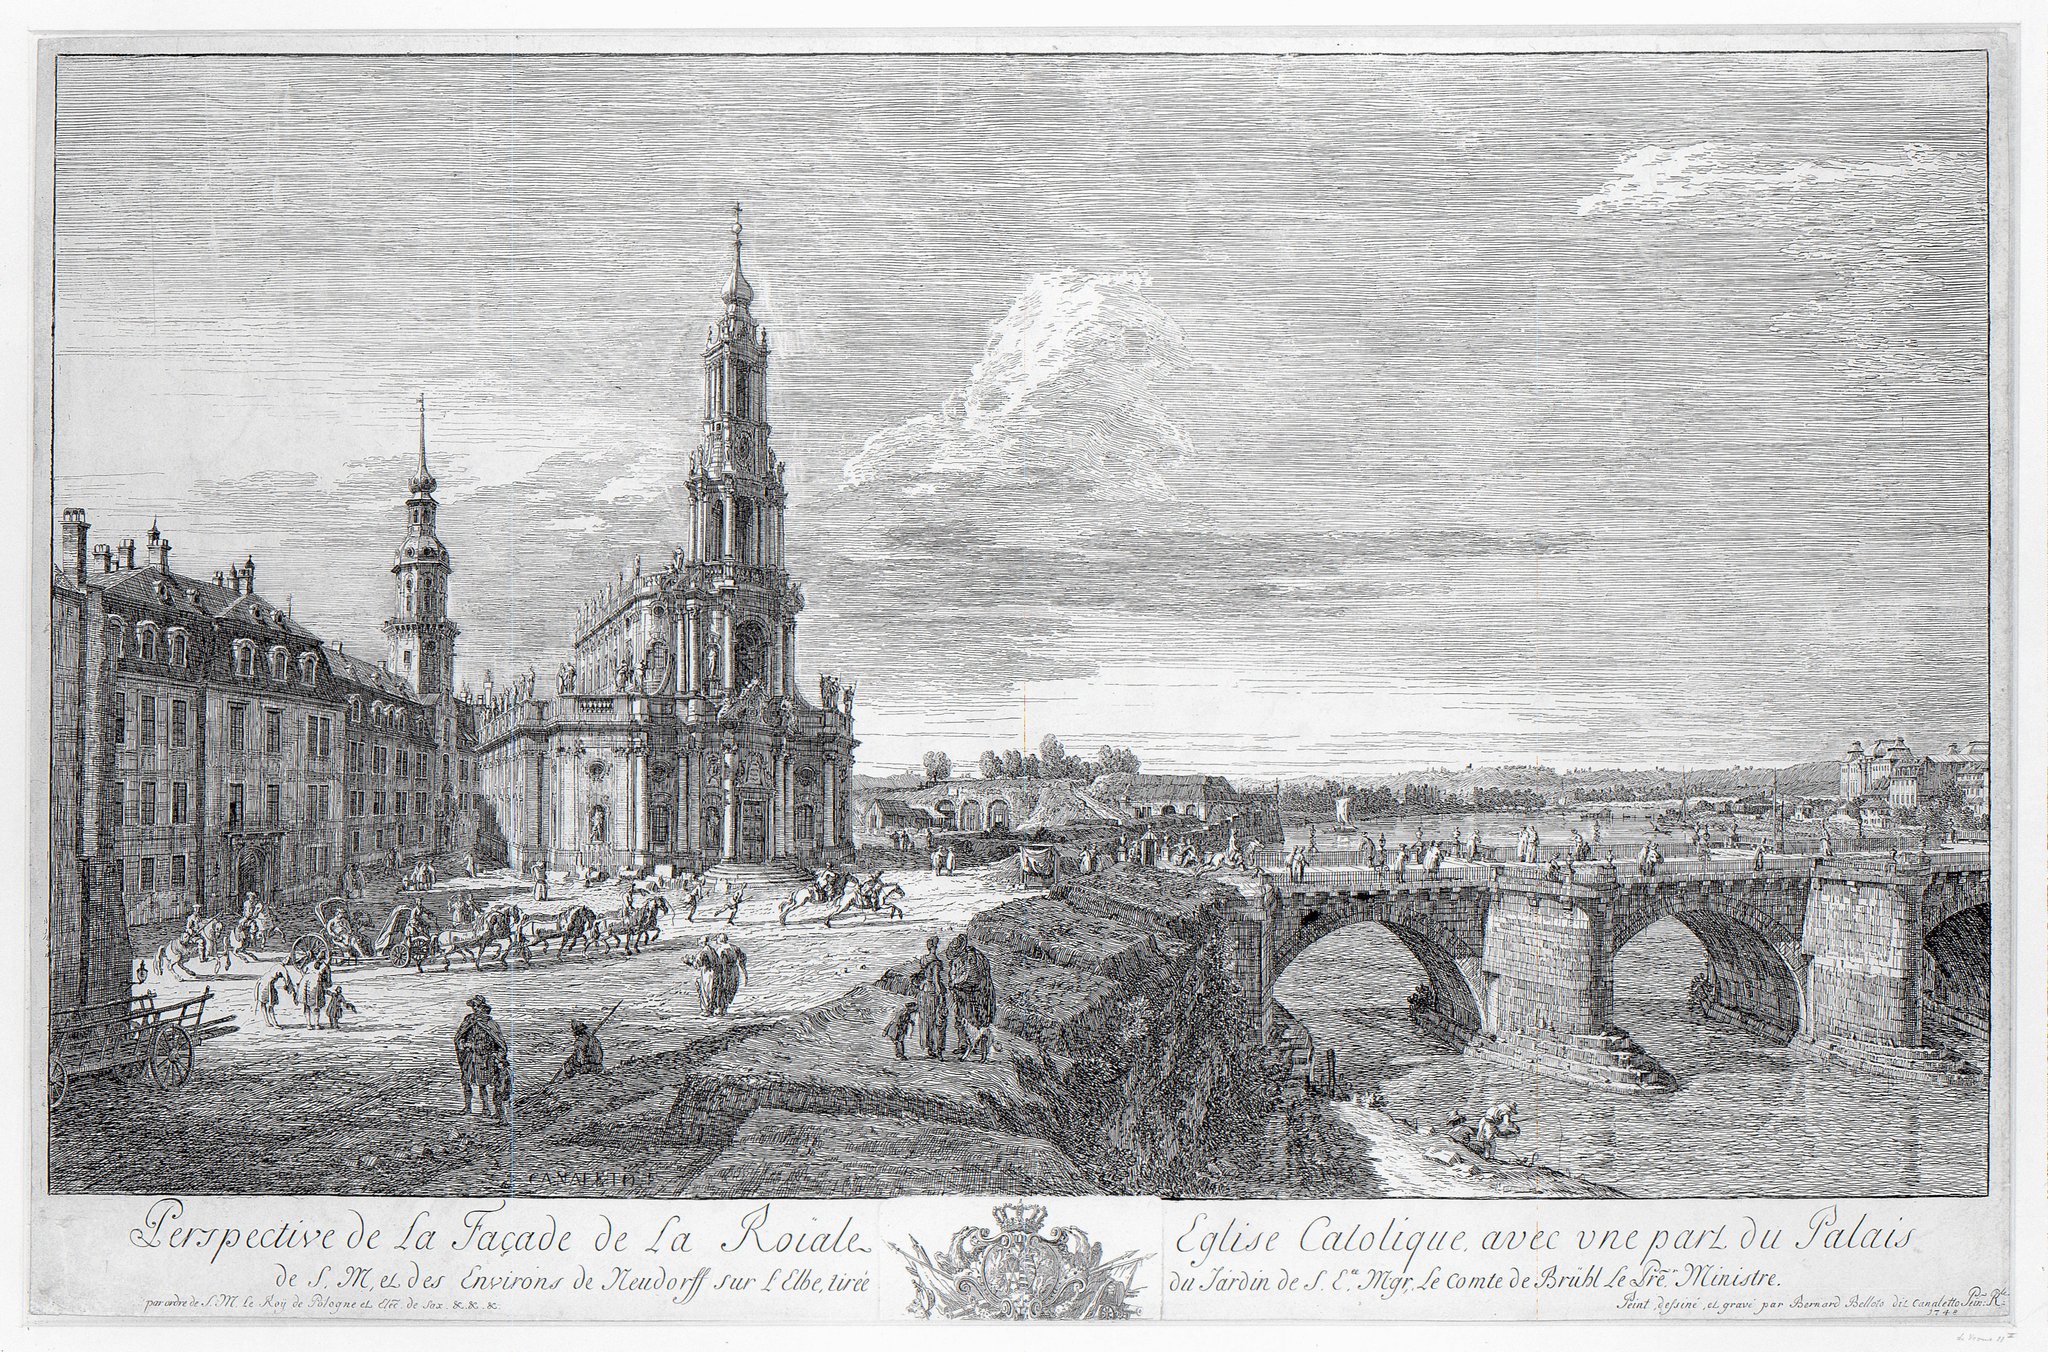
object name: print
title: Katholische Hofkirche te Dresden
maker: bernardo bellotto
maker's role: draughtsman, painter, print maker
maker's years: 1721-1780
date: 1748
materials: paper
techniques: etching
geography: italy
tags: city-view, and landscape with man-made constructions, river, church (exterior)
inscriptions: collector's mark: Lugt 2228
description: Gezicht op de Katholische Hofkirche aan de Elbe te Dresden. Titel en wapenschild in ondermarge.